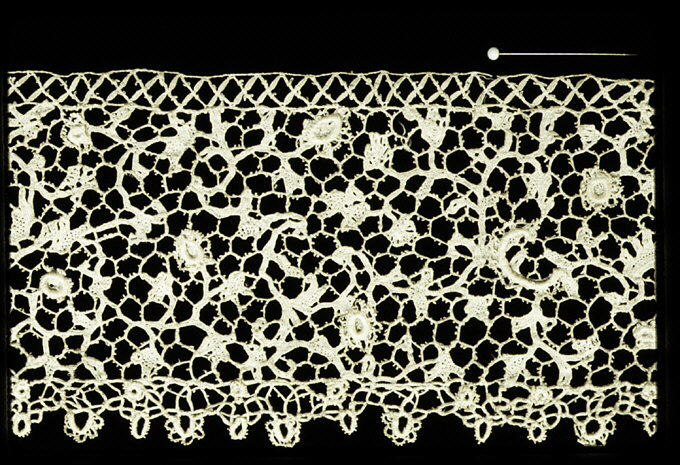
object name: border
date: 1601-1800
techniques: lace